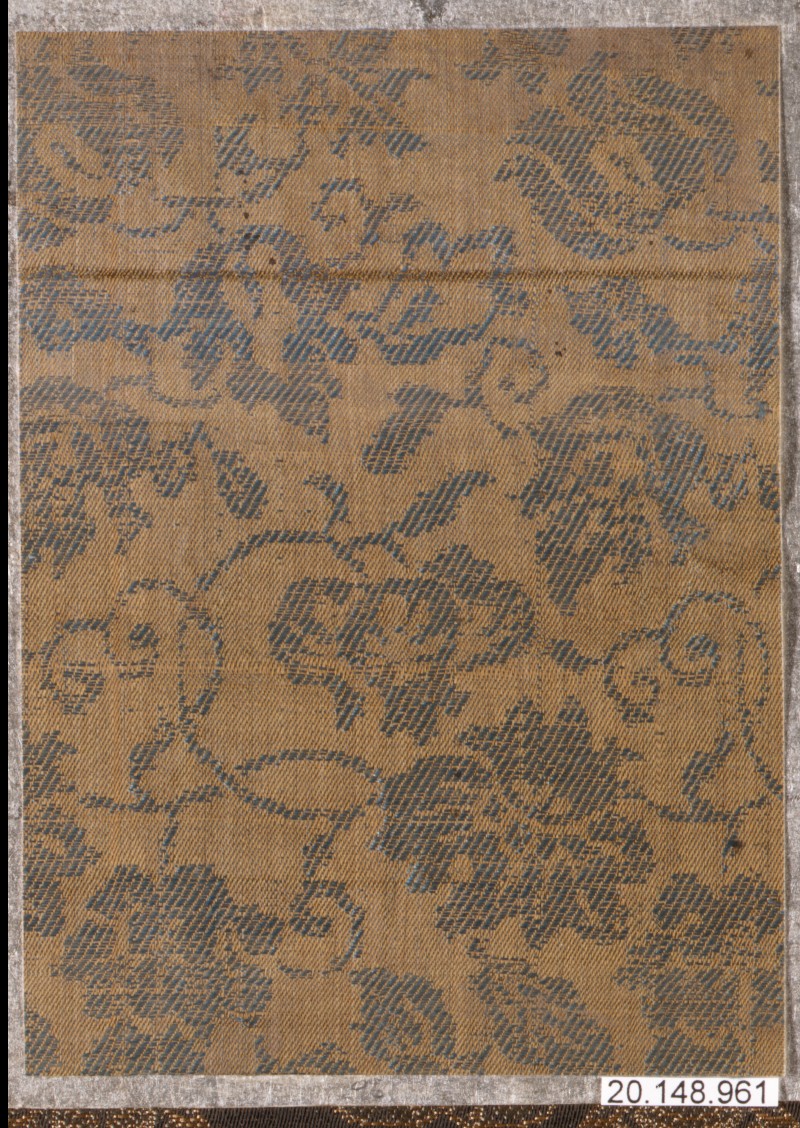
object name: piece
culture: japanese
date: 1701-1800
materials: silk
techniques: compound weave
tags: flowers